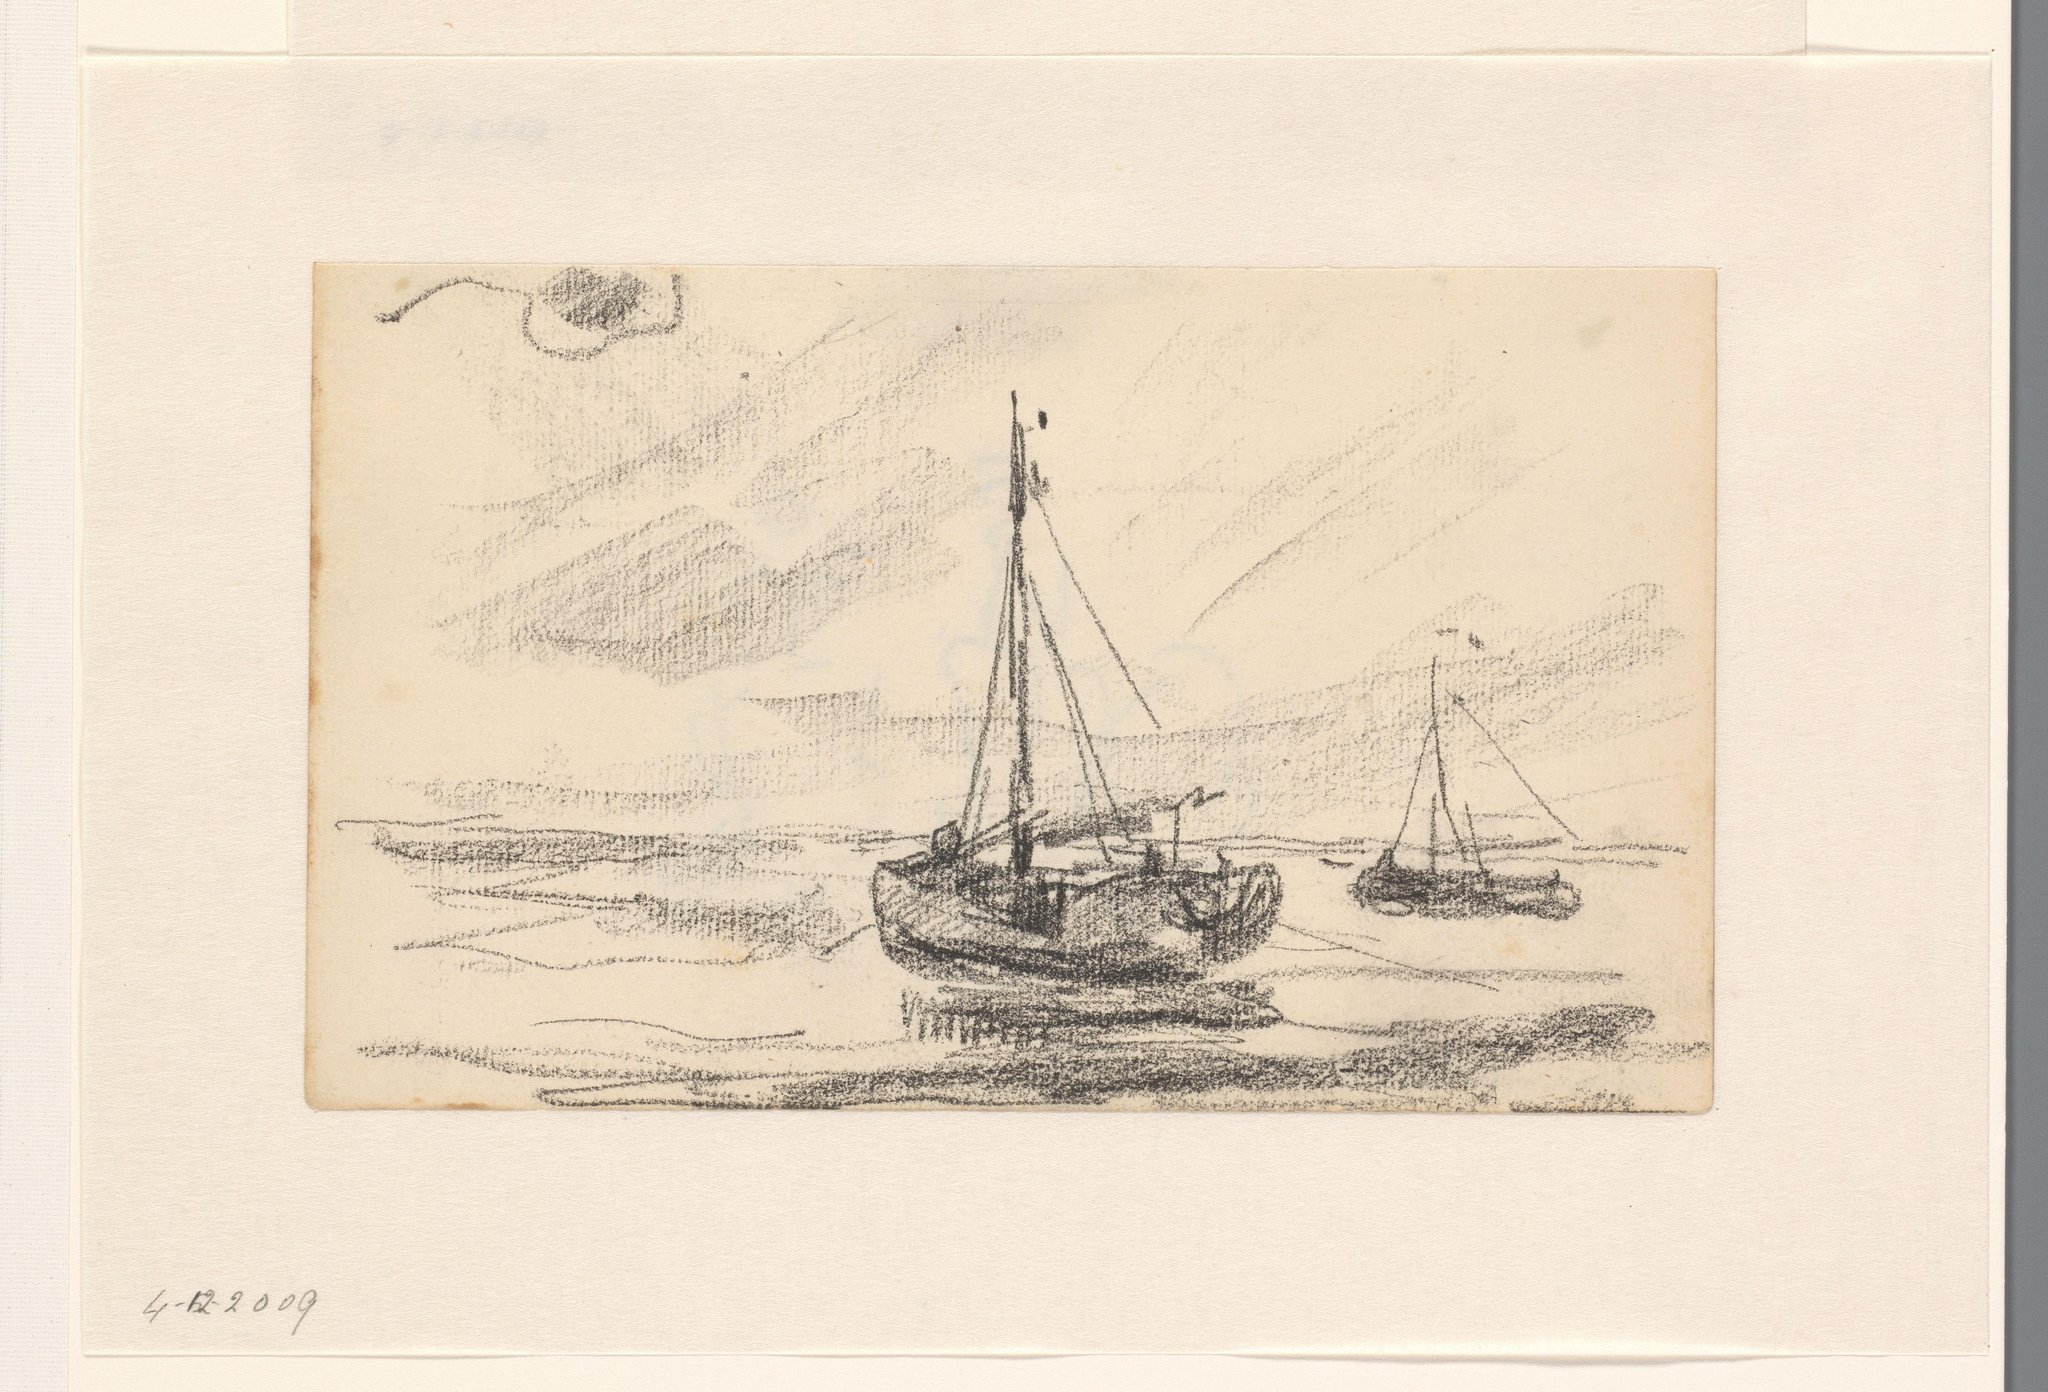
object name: drawing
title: Twee vissersboten op zee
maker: willem bastiaan tholen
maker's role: draughtsman, painter, print maker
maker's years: 1860-1931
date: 1870-1931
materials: chalk, paper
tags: ships (in general)